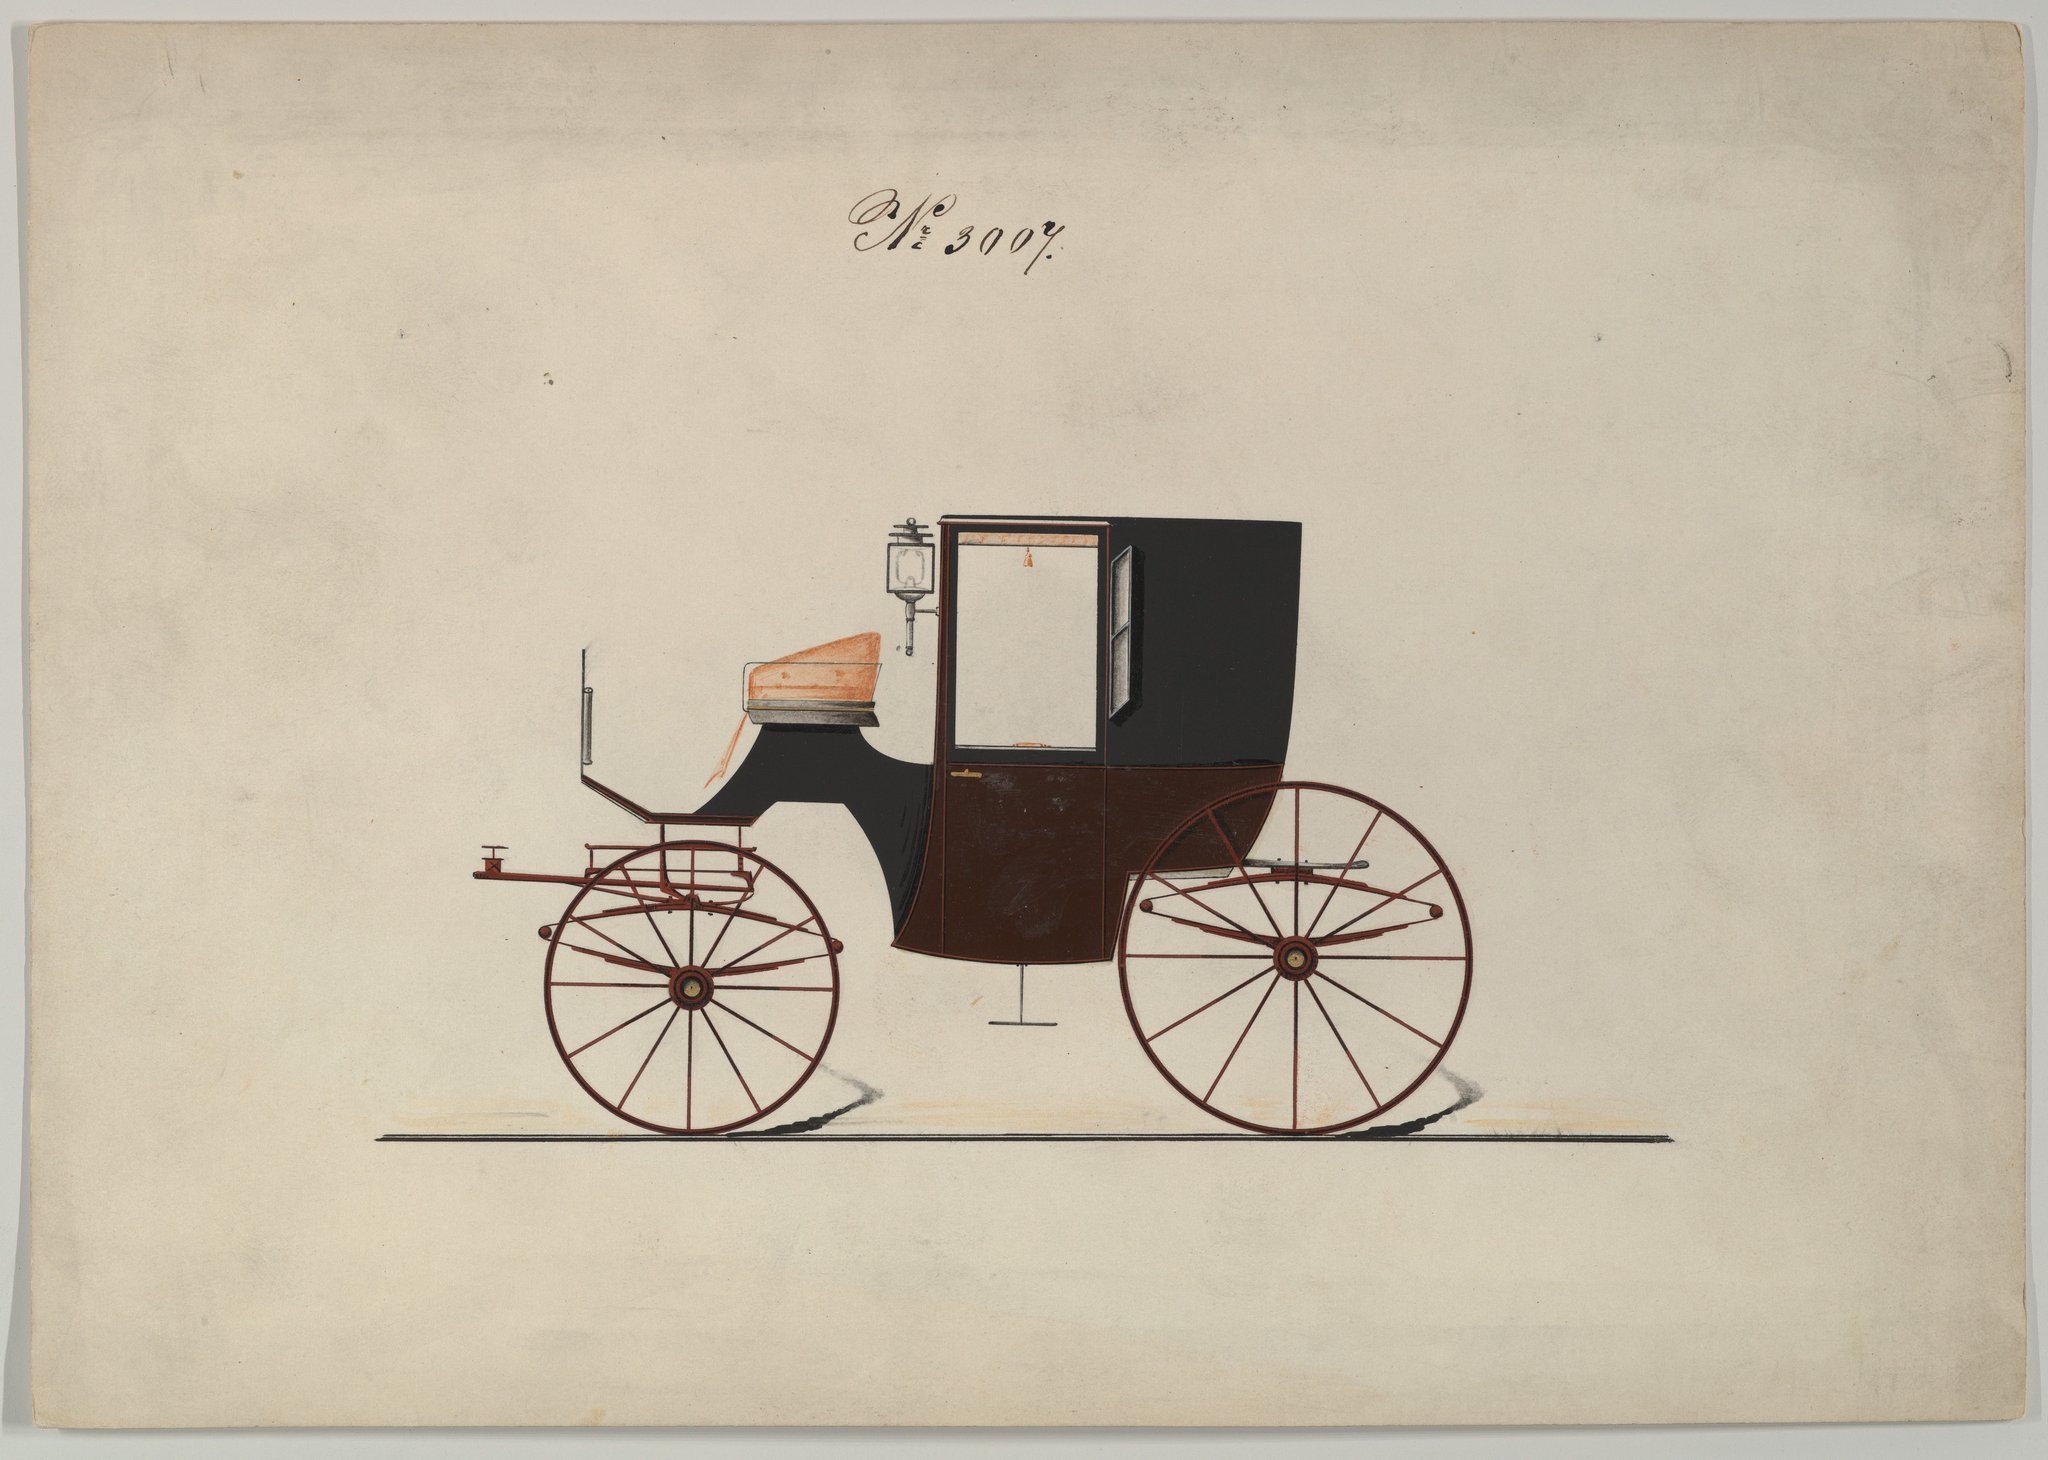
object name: drawing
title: Brougham #3007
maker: brewster & co.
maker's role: manufacturer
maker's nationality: american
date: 1874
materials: gouache, gum arabic, ink, watercolor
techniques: pen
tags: carriages